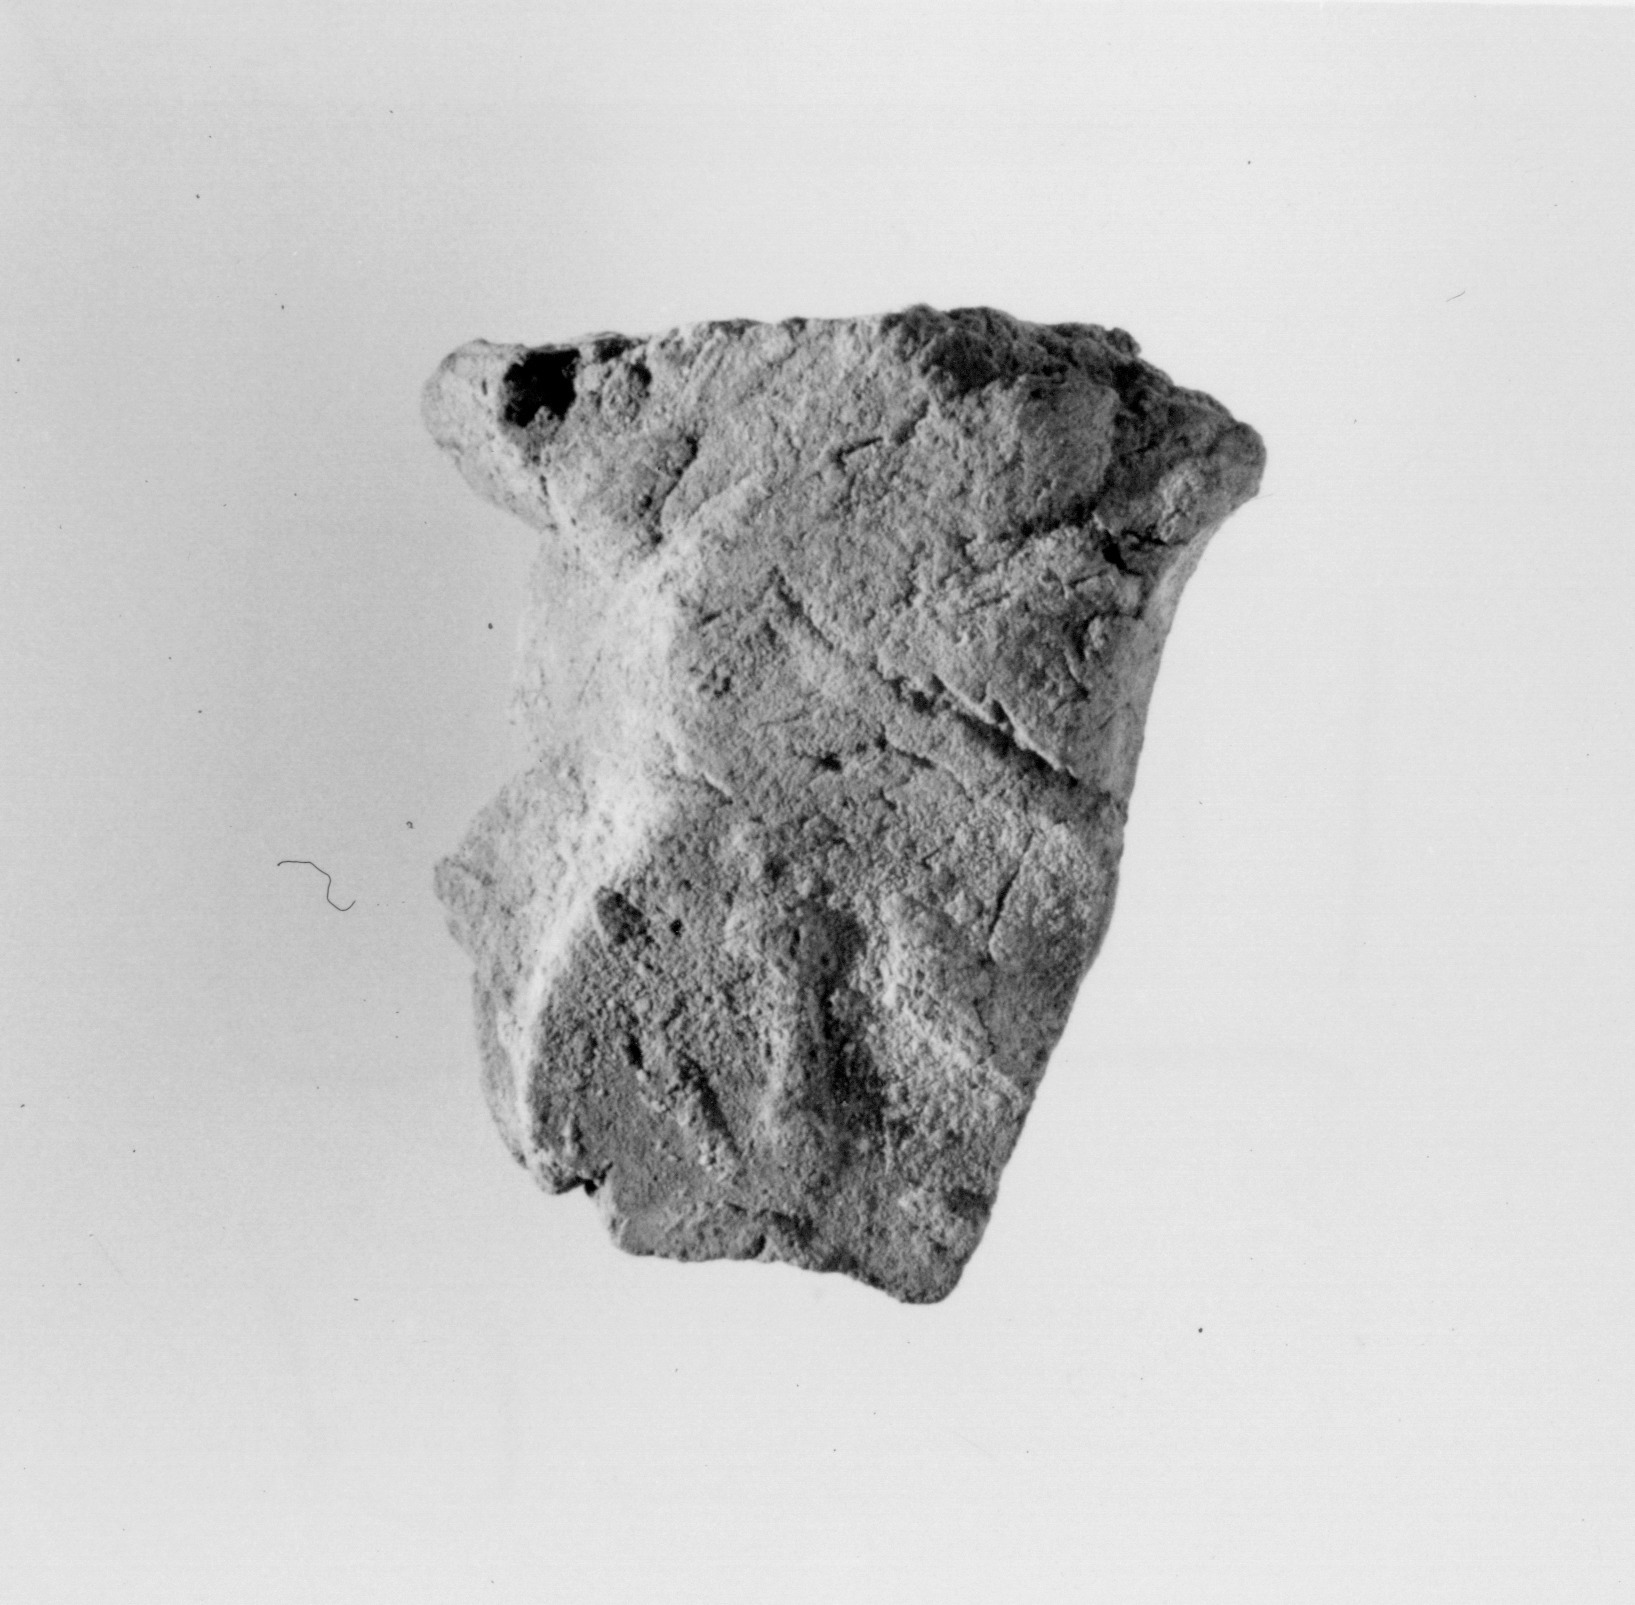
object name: sealing, nebmaatre, amenhotep iii, isi, horus, ke nesu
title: Document Sealing With the Throne Name of Amenhotep III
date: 1390-1352 BCE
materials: mud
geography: egypt